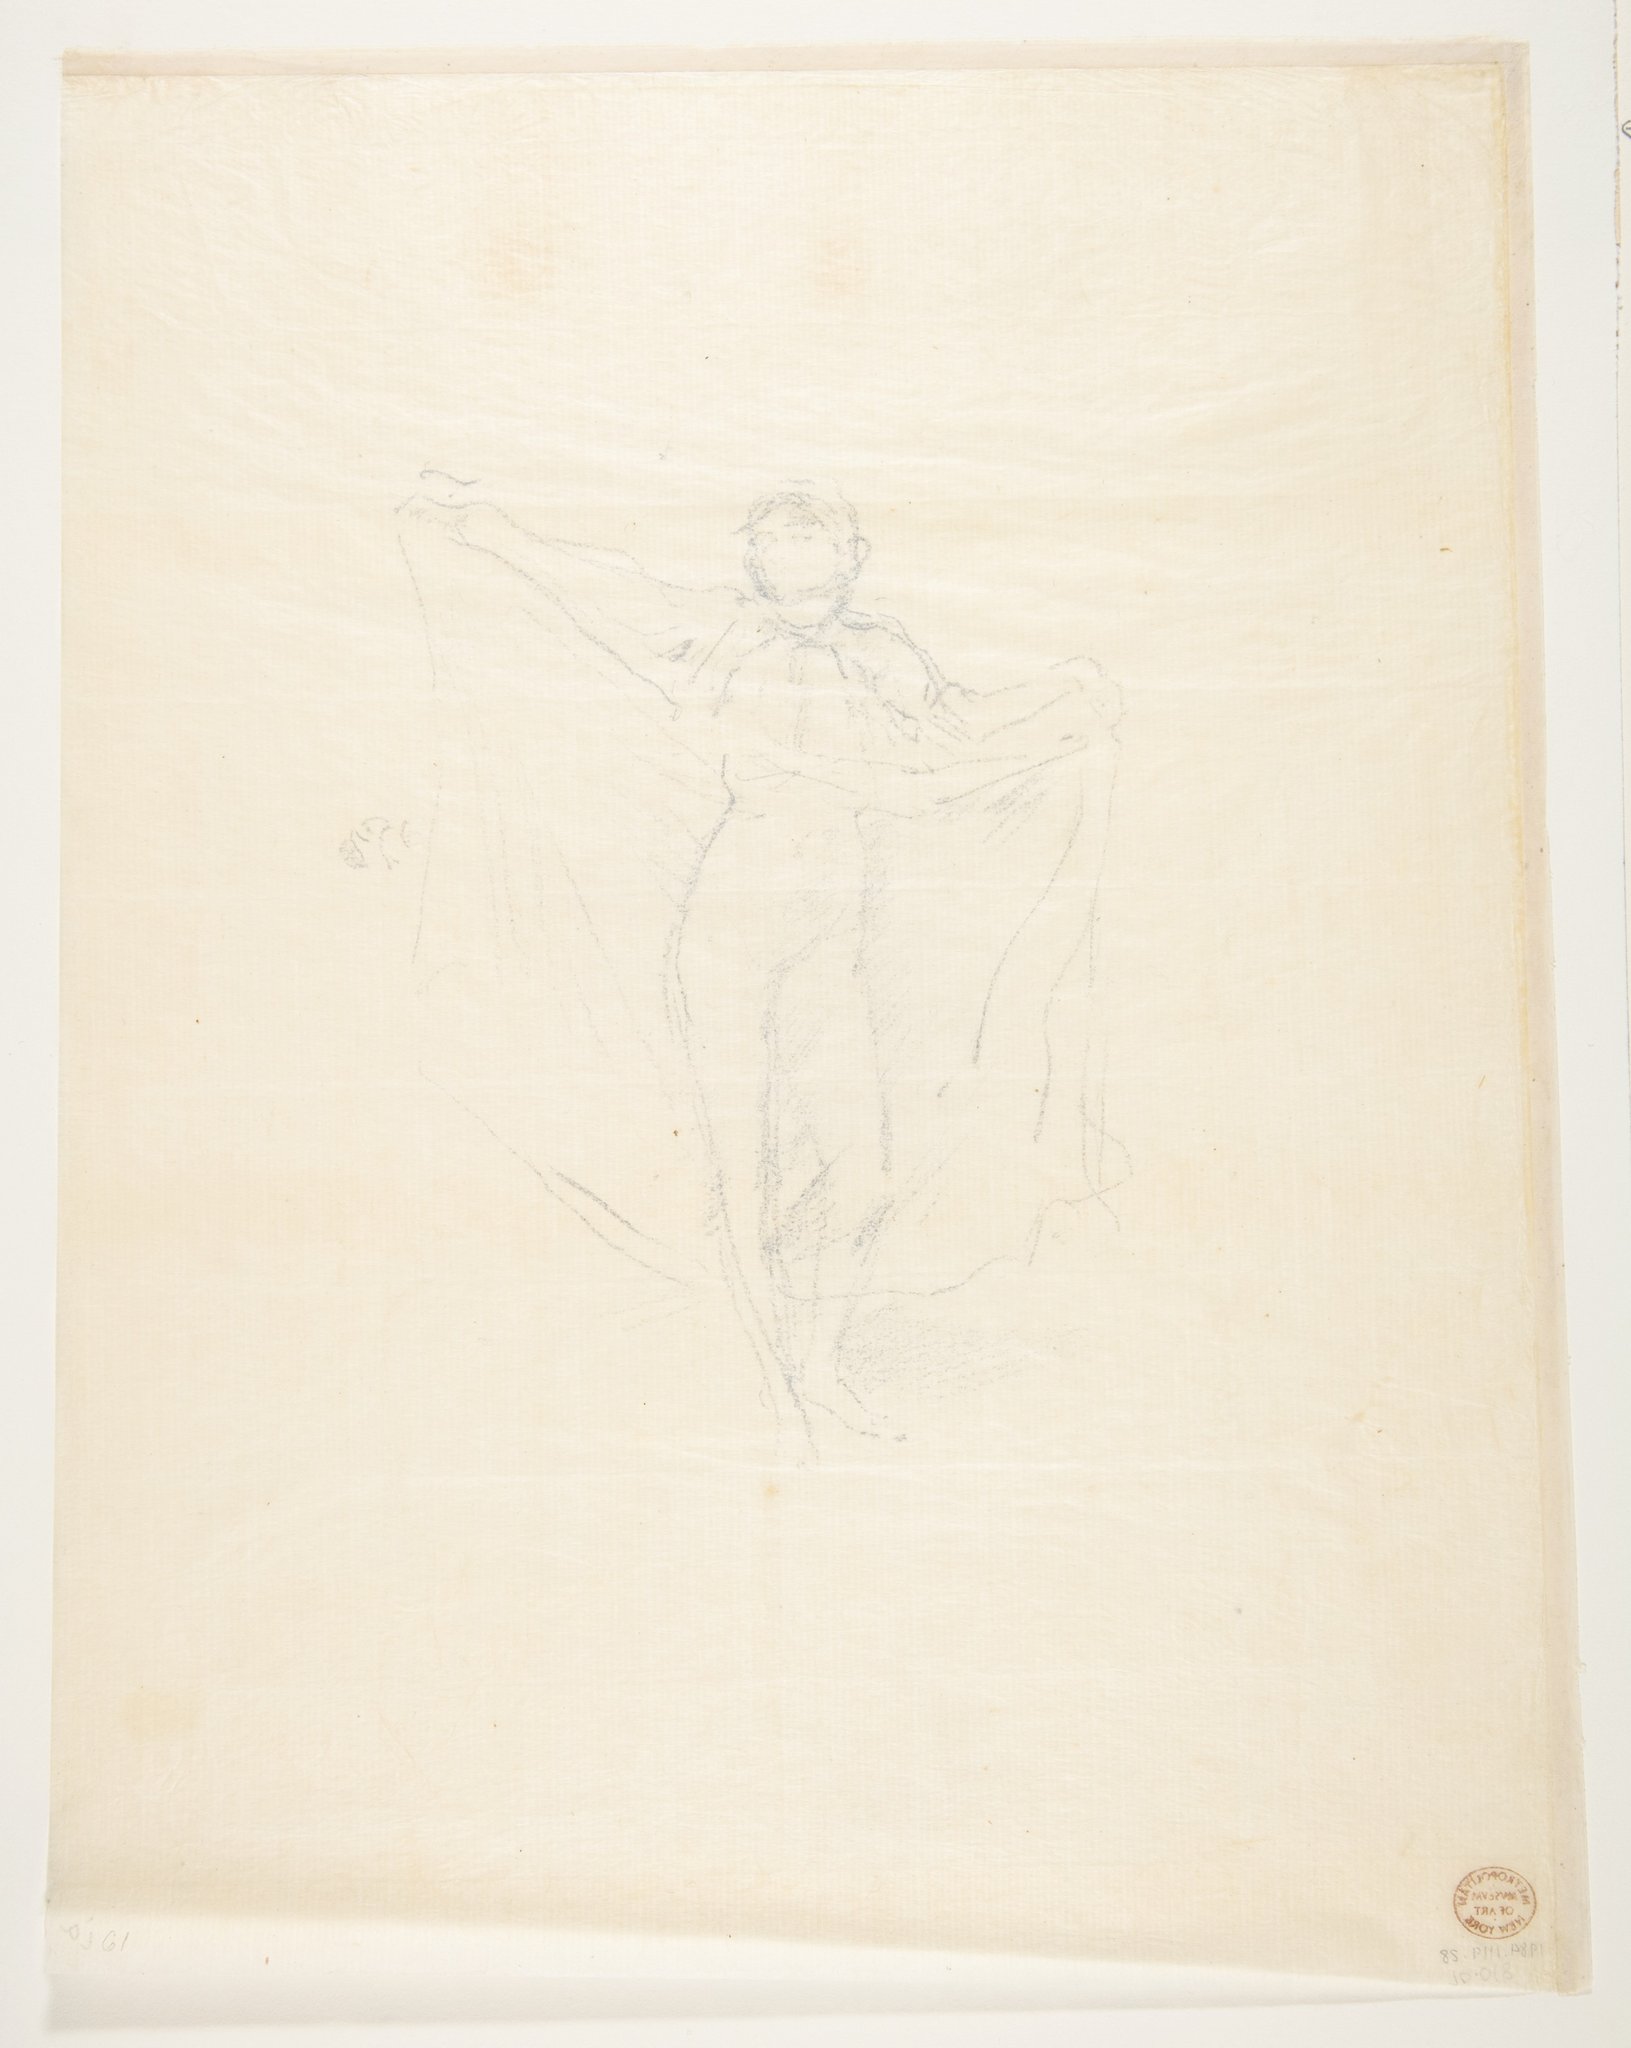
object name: print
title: La Danseuse: A Study of the Nude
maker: james mcneill whistler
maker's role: artist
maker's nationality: american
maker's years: 1834-1903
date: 1891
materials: ink, paper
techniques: printing, lithography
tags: female nudes,dancers